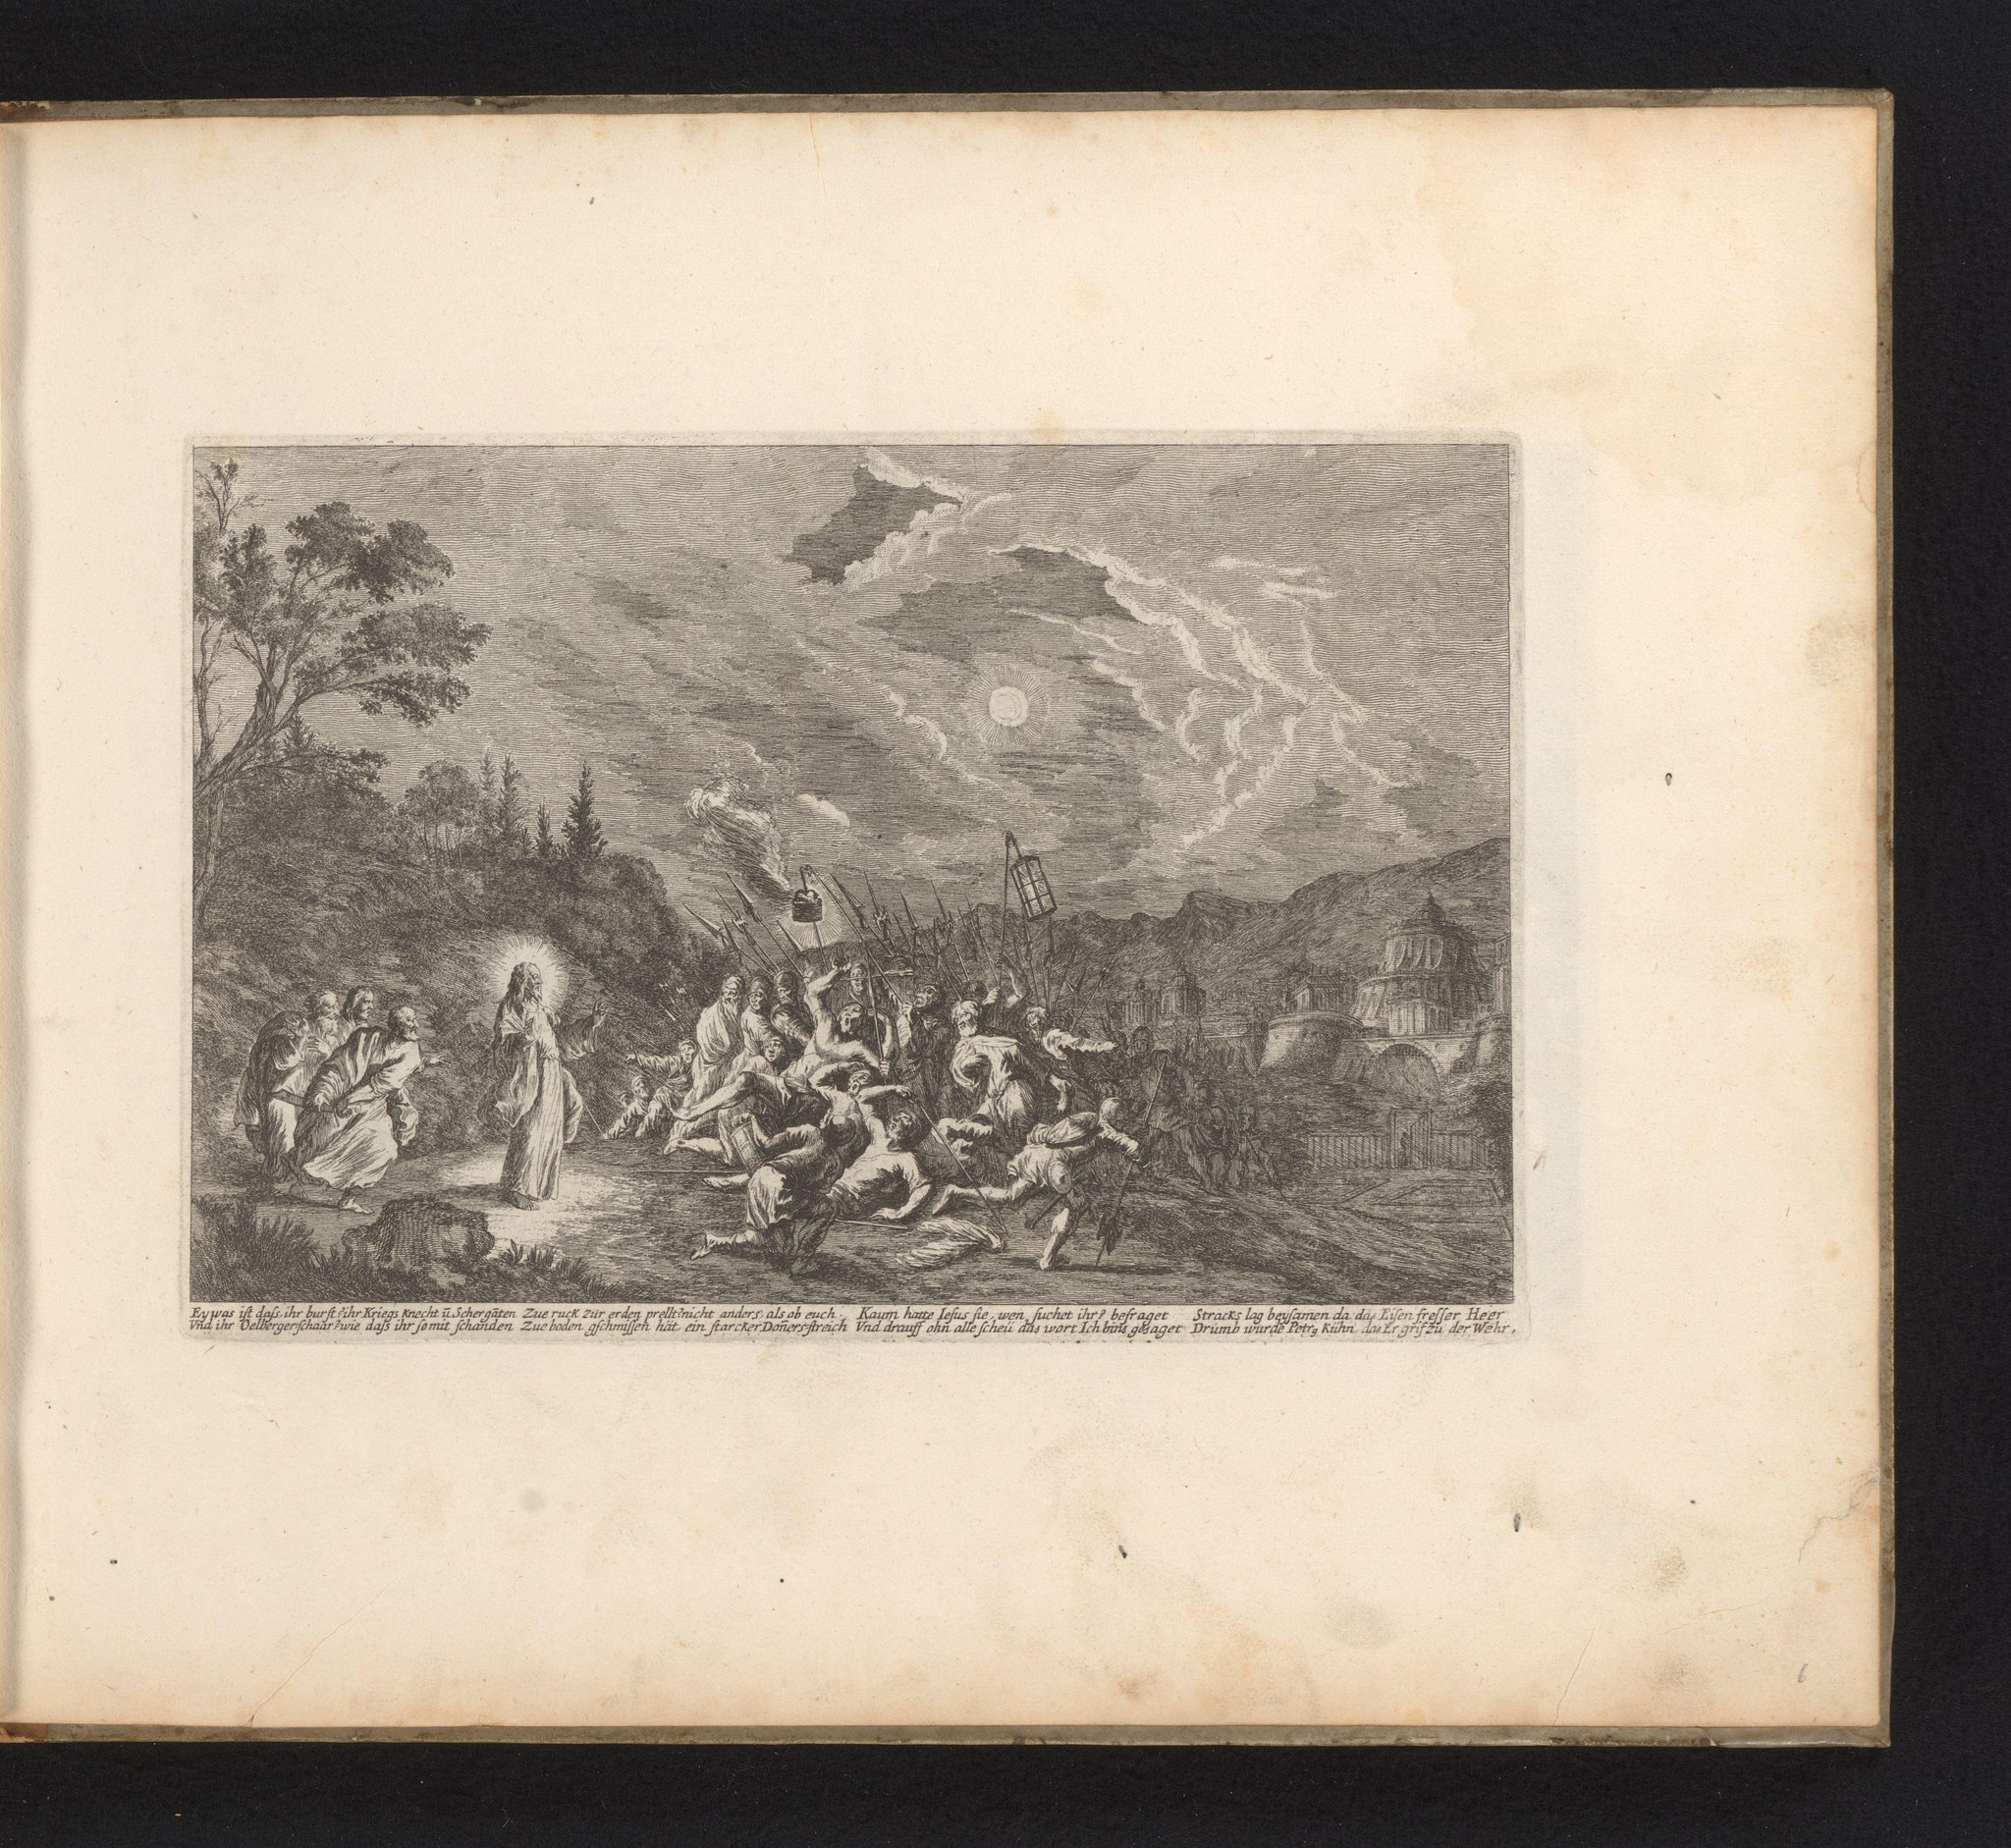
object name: album leaf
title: Gevangenneming van Christus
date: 1670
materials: paper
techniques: etching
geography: augsburg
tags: peter draws his sword and cuts off malchus' ear, the arrest of christ ~ garden of gethsemane, christ makes himself known; the soldiers fall to the ground ~ the kiss of judas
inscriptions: collector's mark: Lugt 2228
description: Christus maakt zich bekend en Petrus trekt zijn zwaard. Tekst in het Duits in de ondermarge. Rechtsonder genummerd: 6. Prent maakt deel uit van een album.